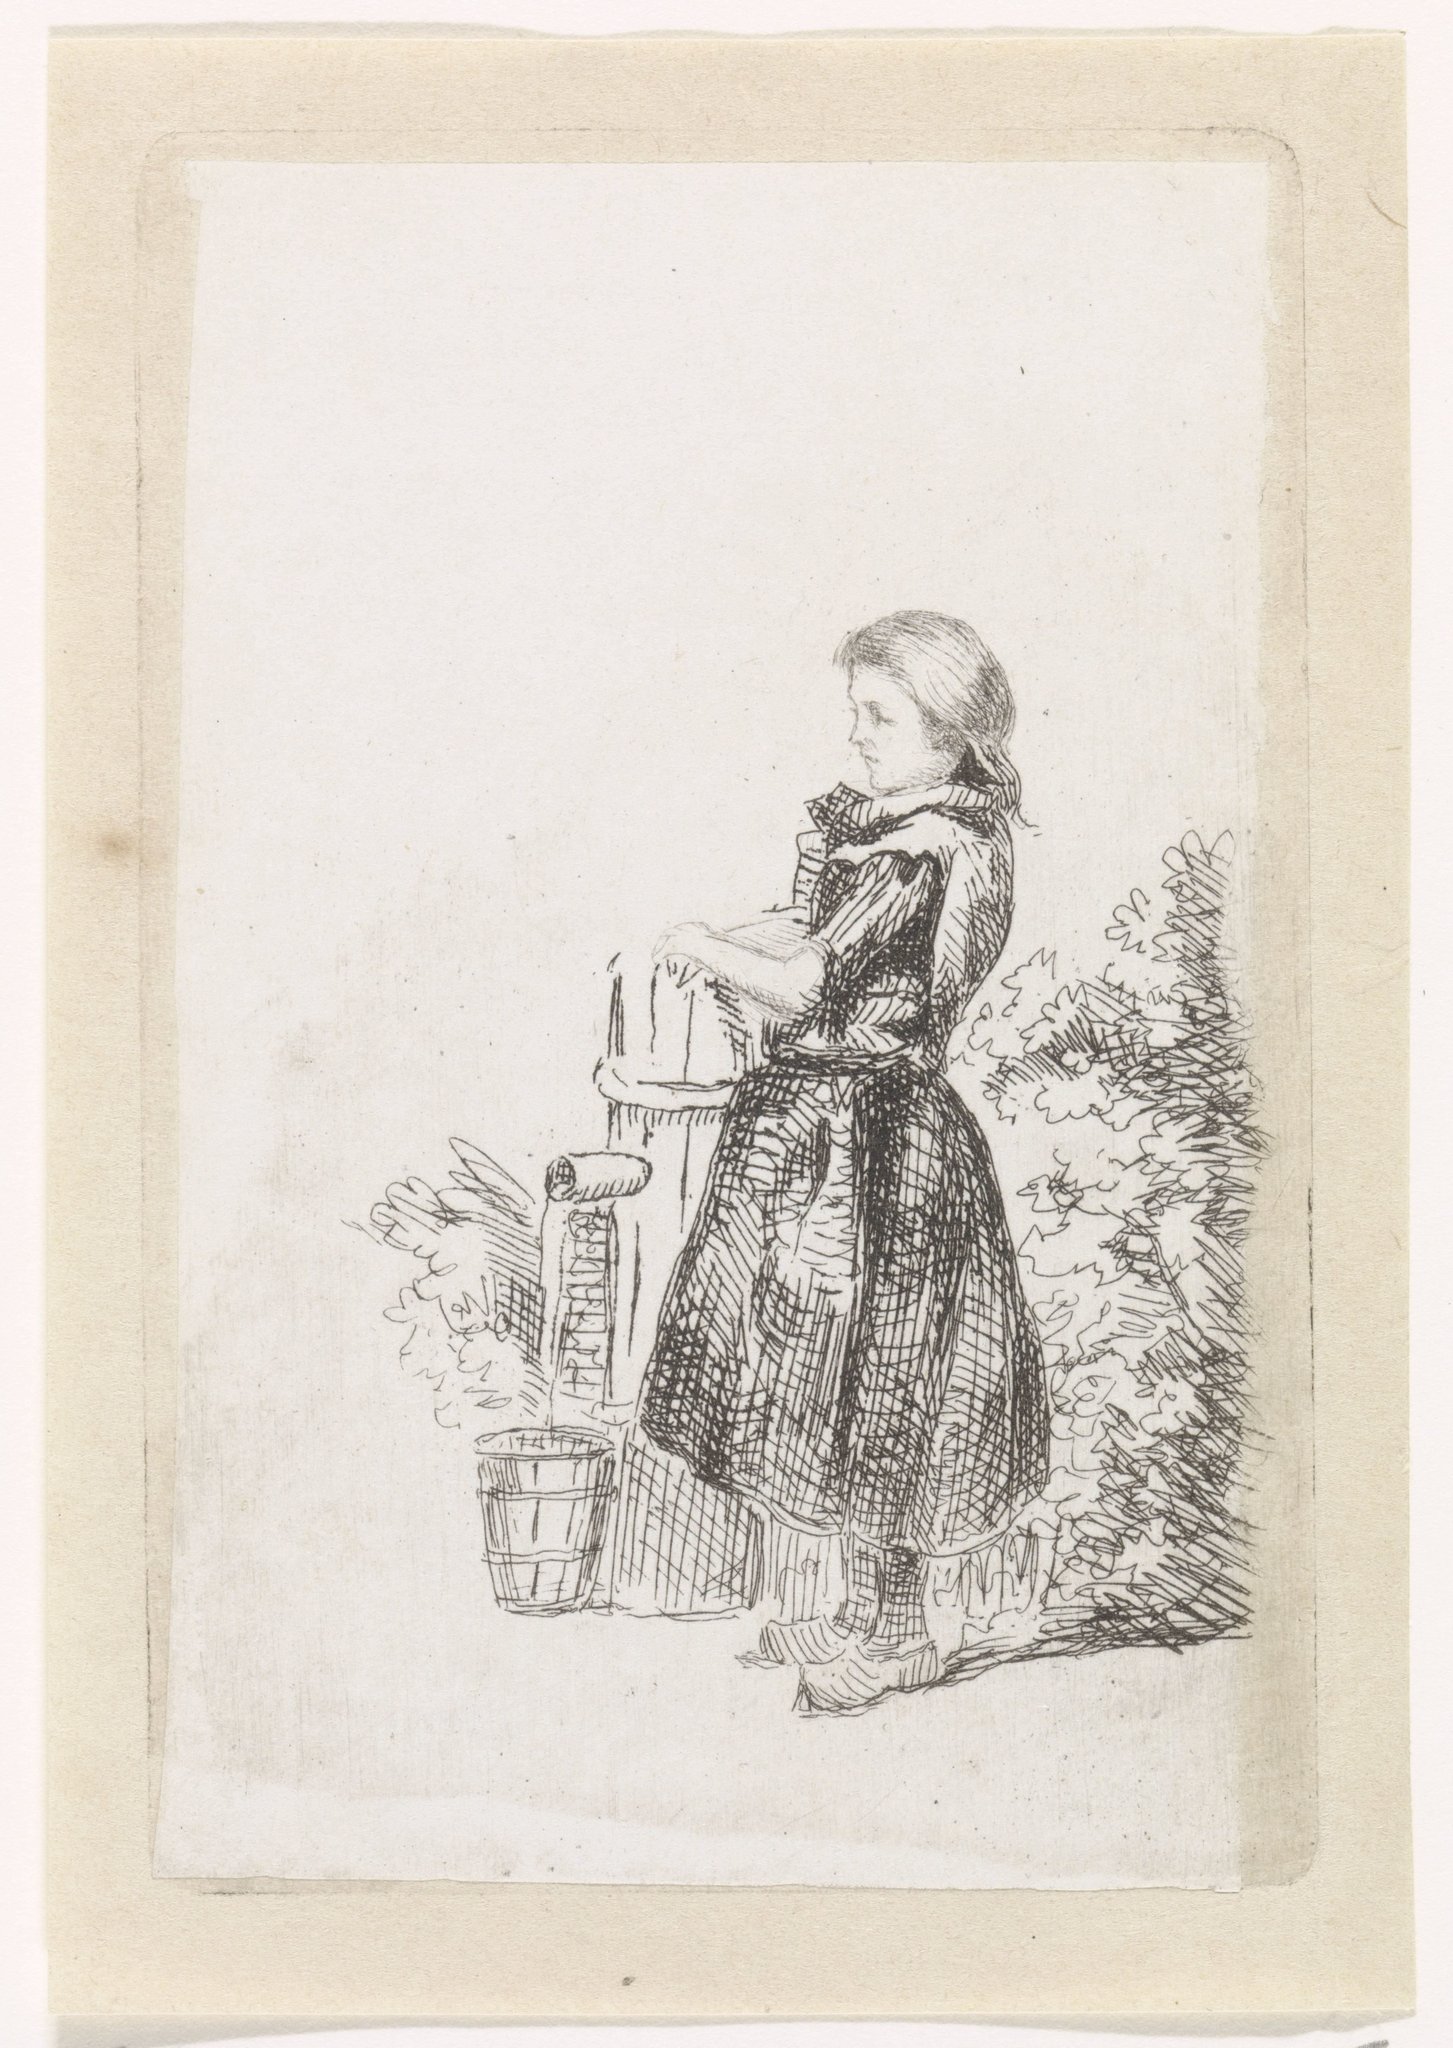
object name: print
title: Meisje bij een waterpomp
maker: kornelis jzn de wijs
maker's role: print maker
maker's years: 1832-1896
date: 1842-1896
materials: paper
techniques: etching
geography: netherlands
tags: girl (child between toddler and youth), utilitarian, public pump or water fountain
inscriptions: collector's mark: Lugt 2228